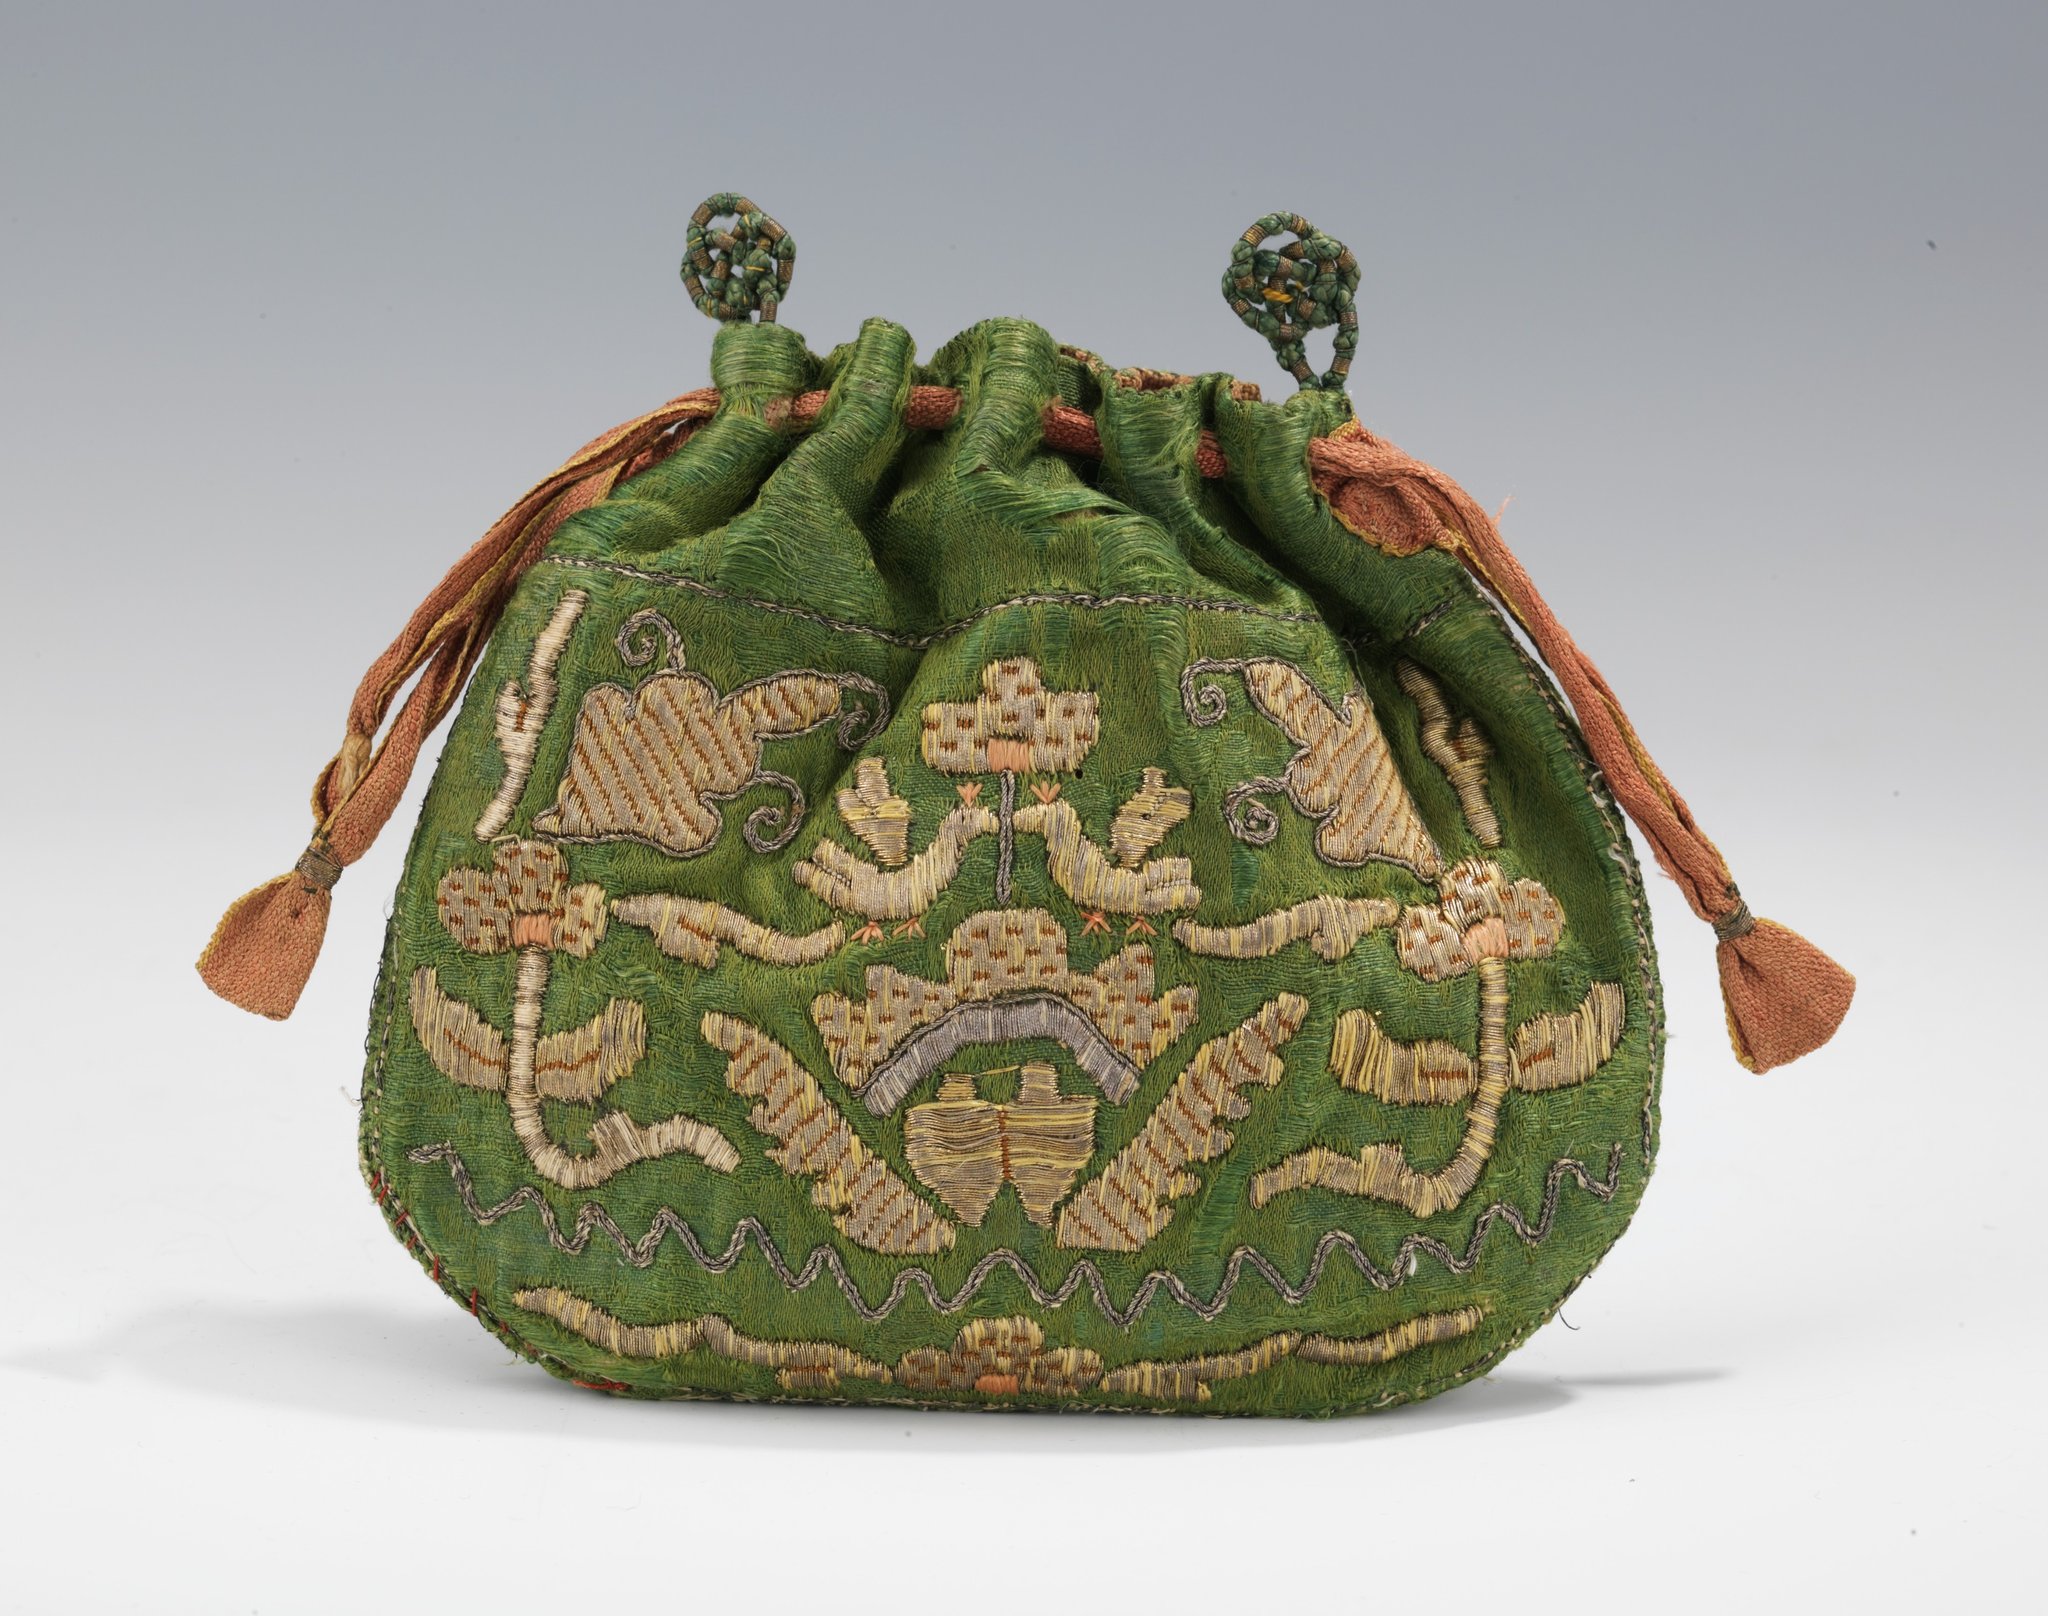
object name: pouch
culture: russian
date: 1701-1725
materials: linen, metal, silk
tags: birds